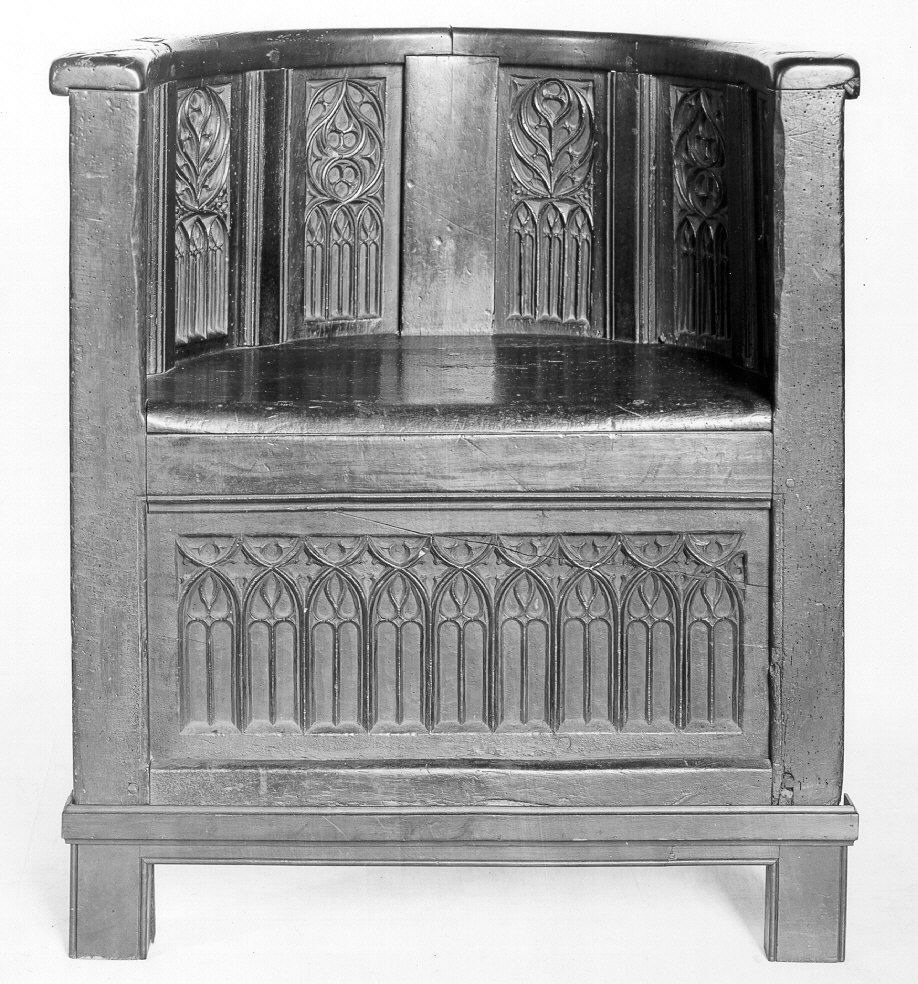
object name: chair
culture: french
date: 1401-1500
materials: wood